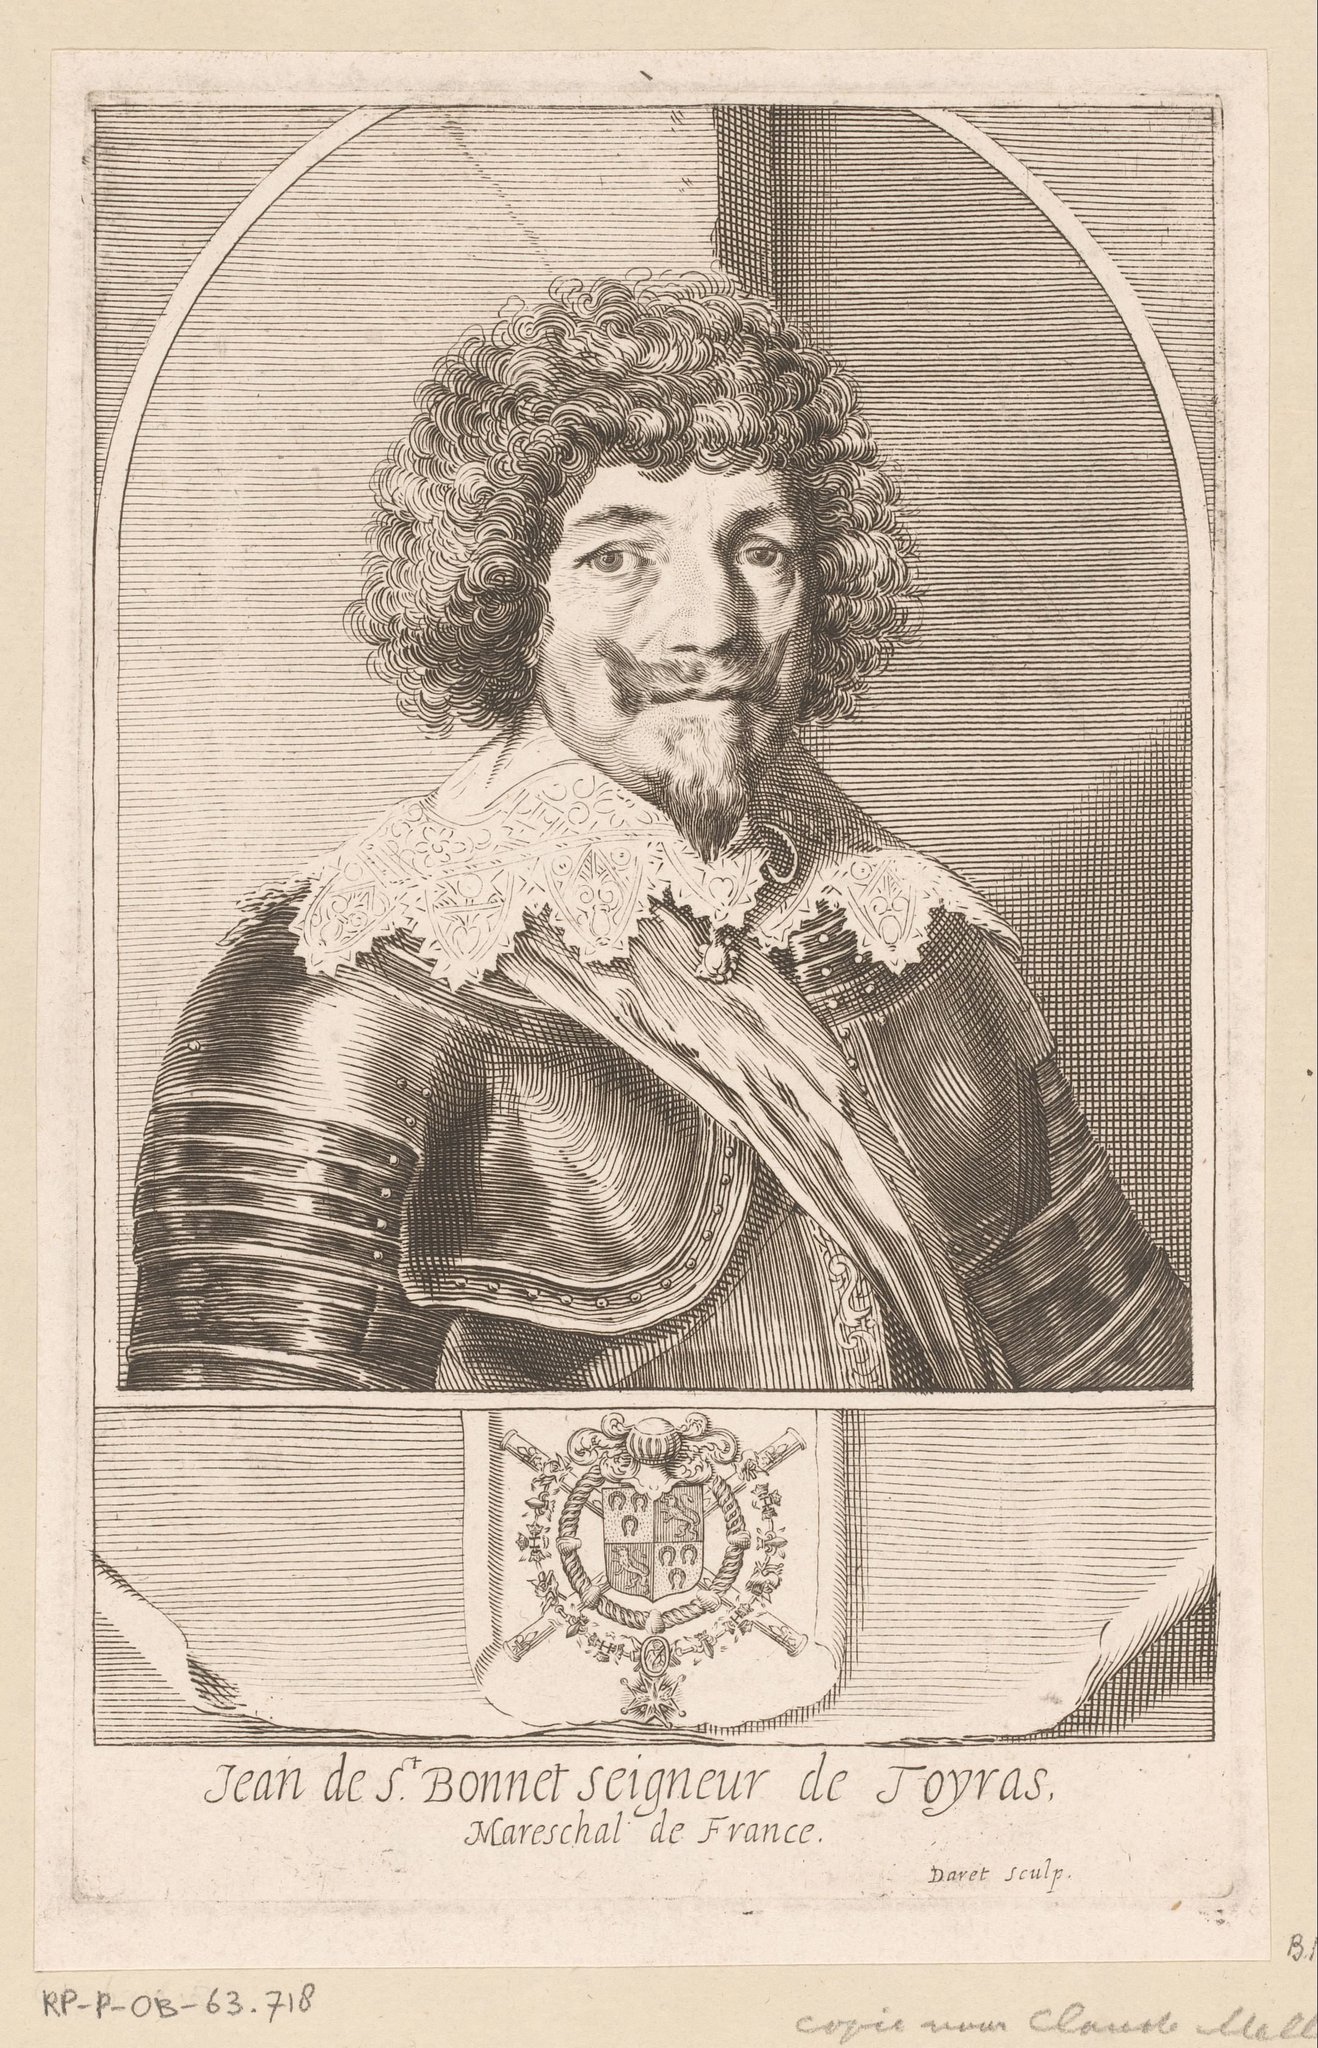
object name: print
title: Portret van Jean Caylar d'Anduze de Saint-Bonnet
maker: pierre daret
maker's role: print maker, publisher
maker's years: 1604-1678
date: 1614-1678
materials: paper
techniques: engraving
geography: france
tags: historical persons, armorial bearing, heraldry